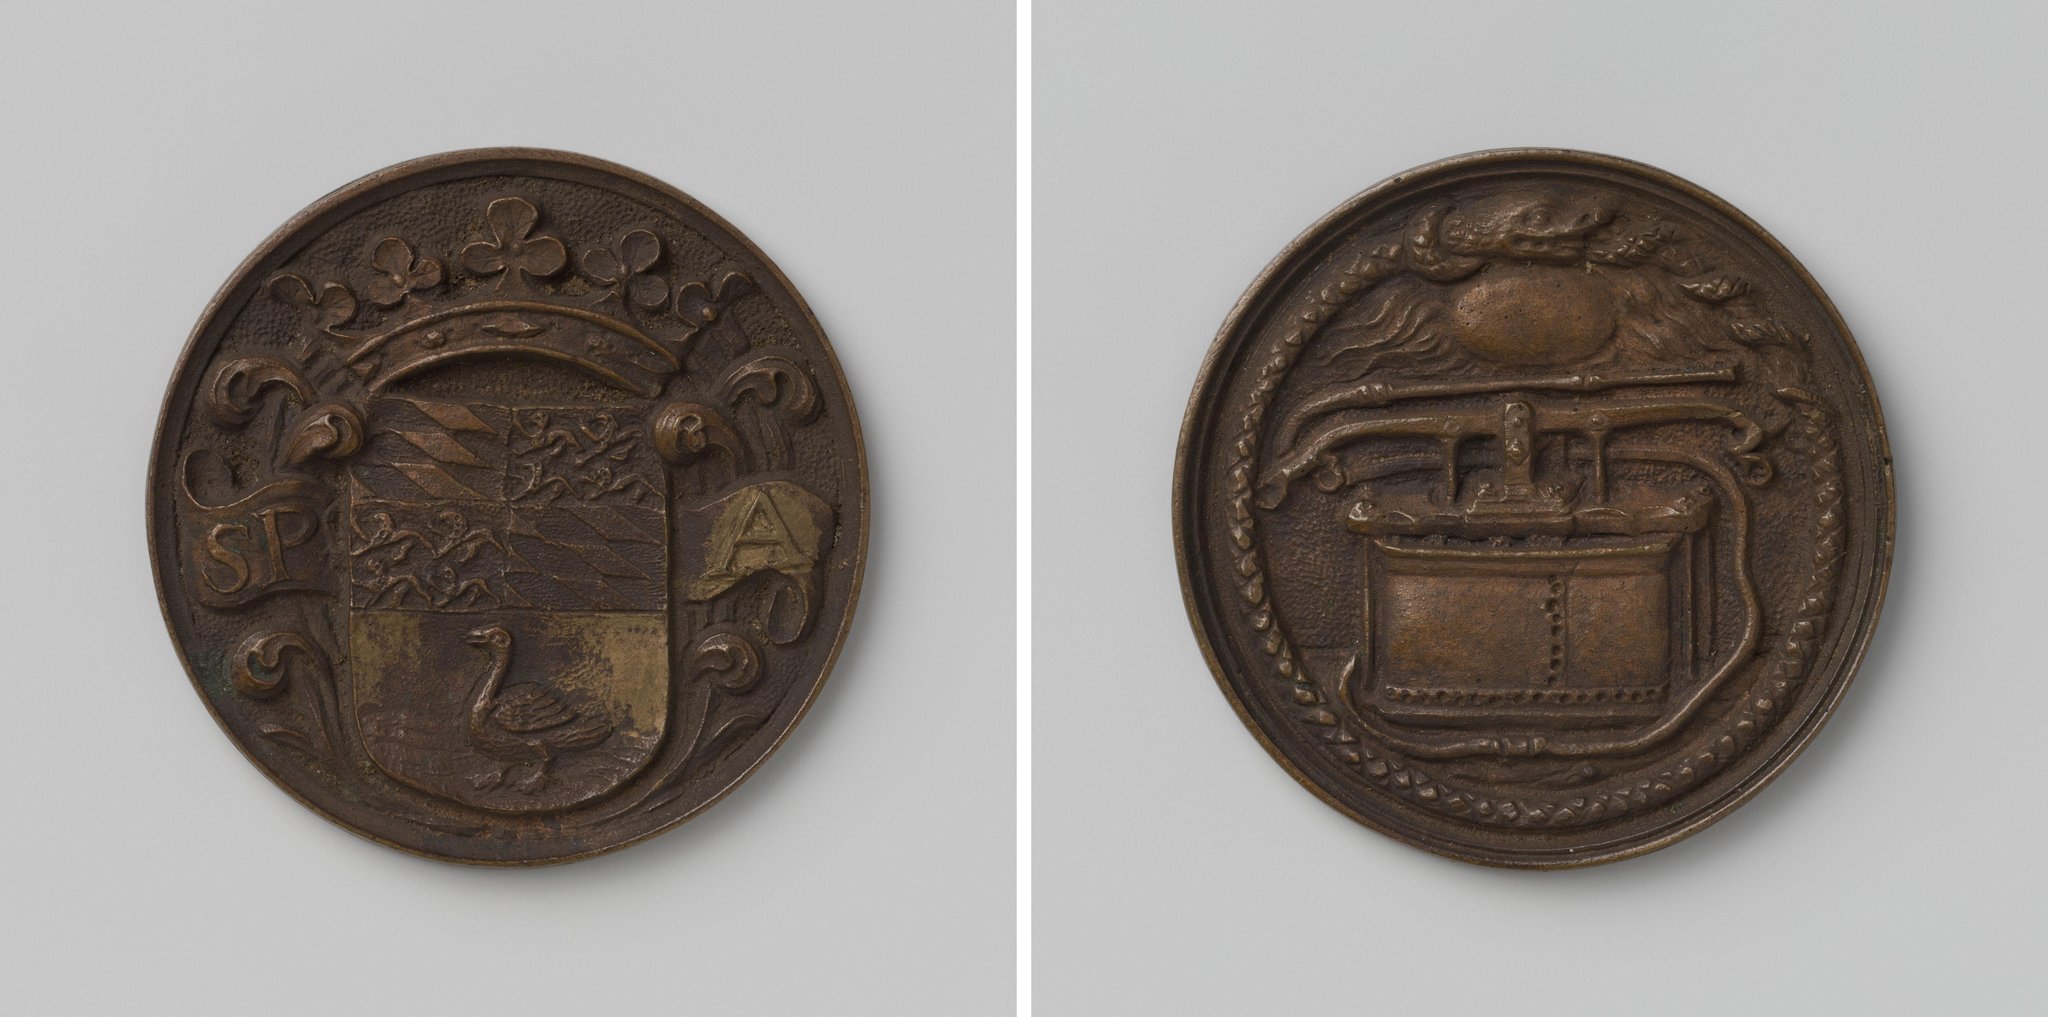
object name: medal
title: Goes, brandspuitpenning van spuit A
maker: Anonymous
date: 1680-1800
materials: brass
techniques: casting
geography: goes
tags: goes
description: Messing penning. Voorzijde: gekroond wapenschild; daarachter: lint met opschrift SP en A. Keerzijde: brandspuit onder leeg cartouche binnen slangerond